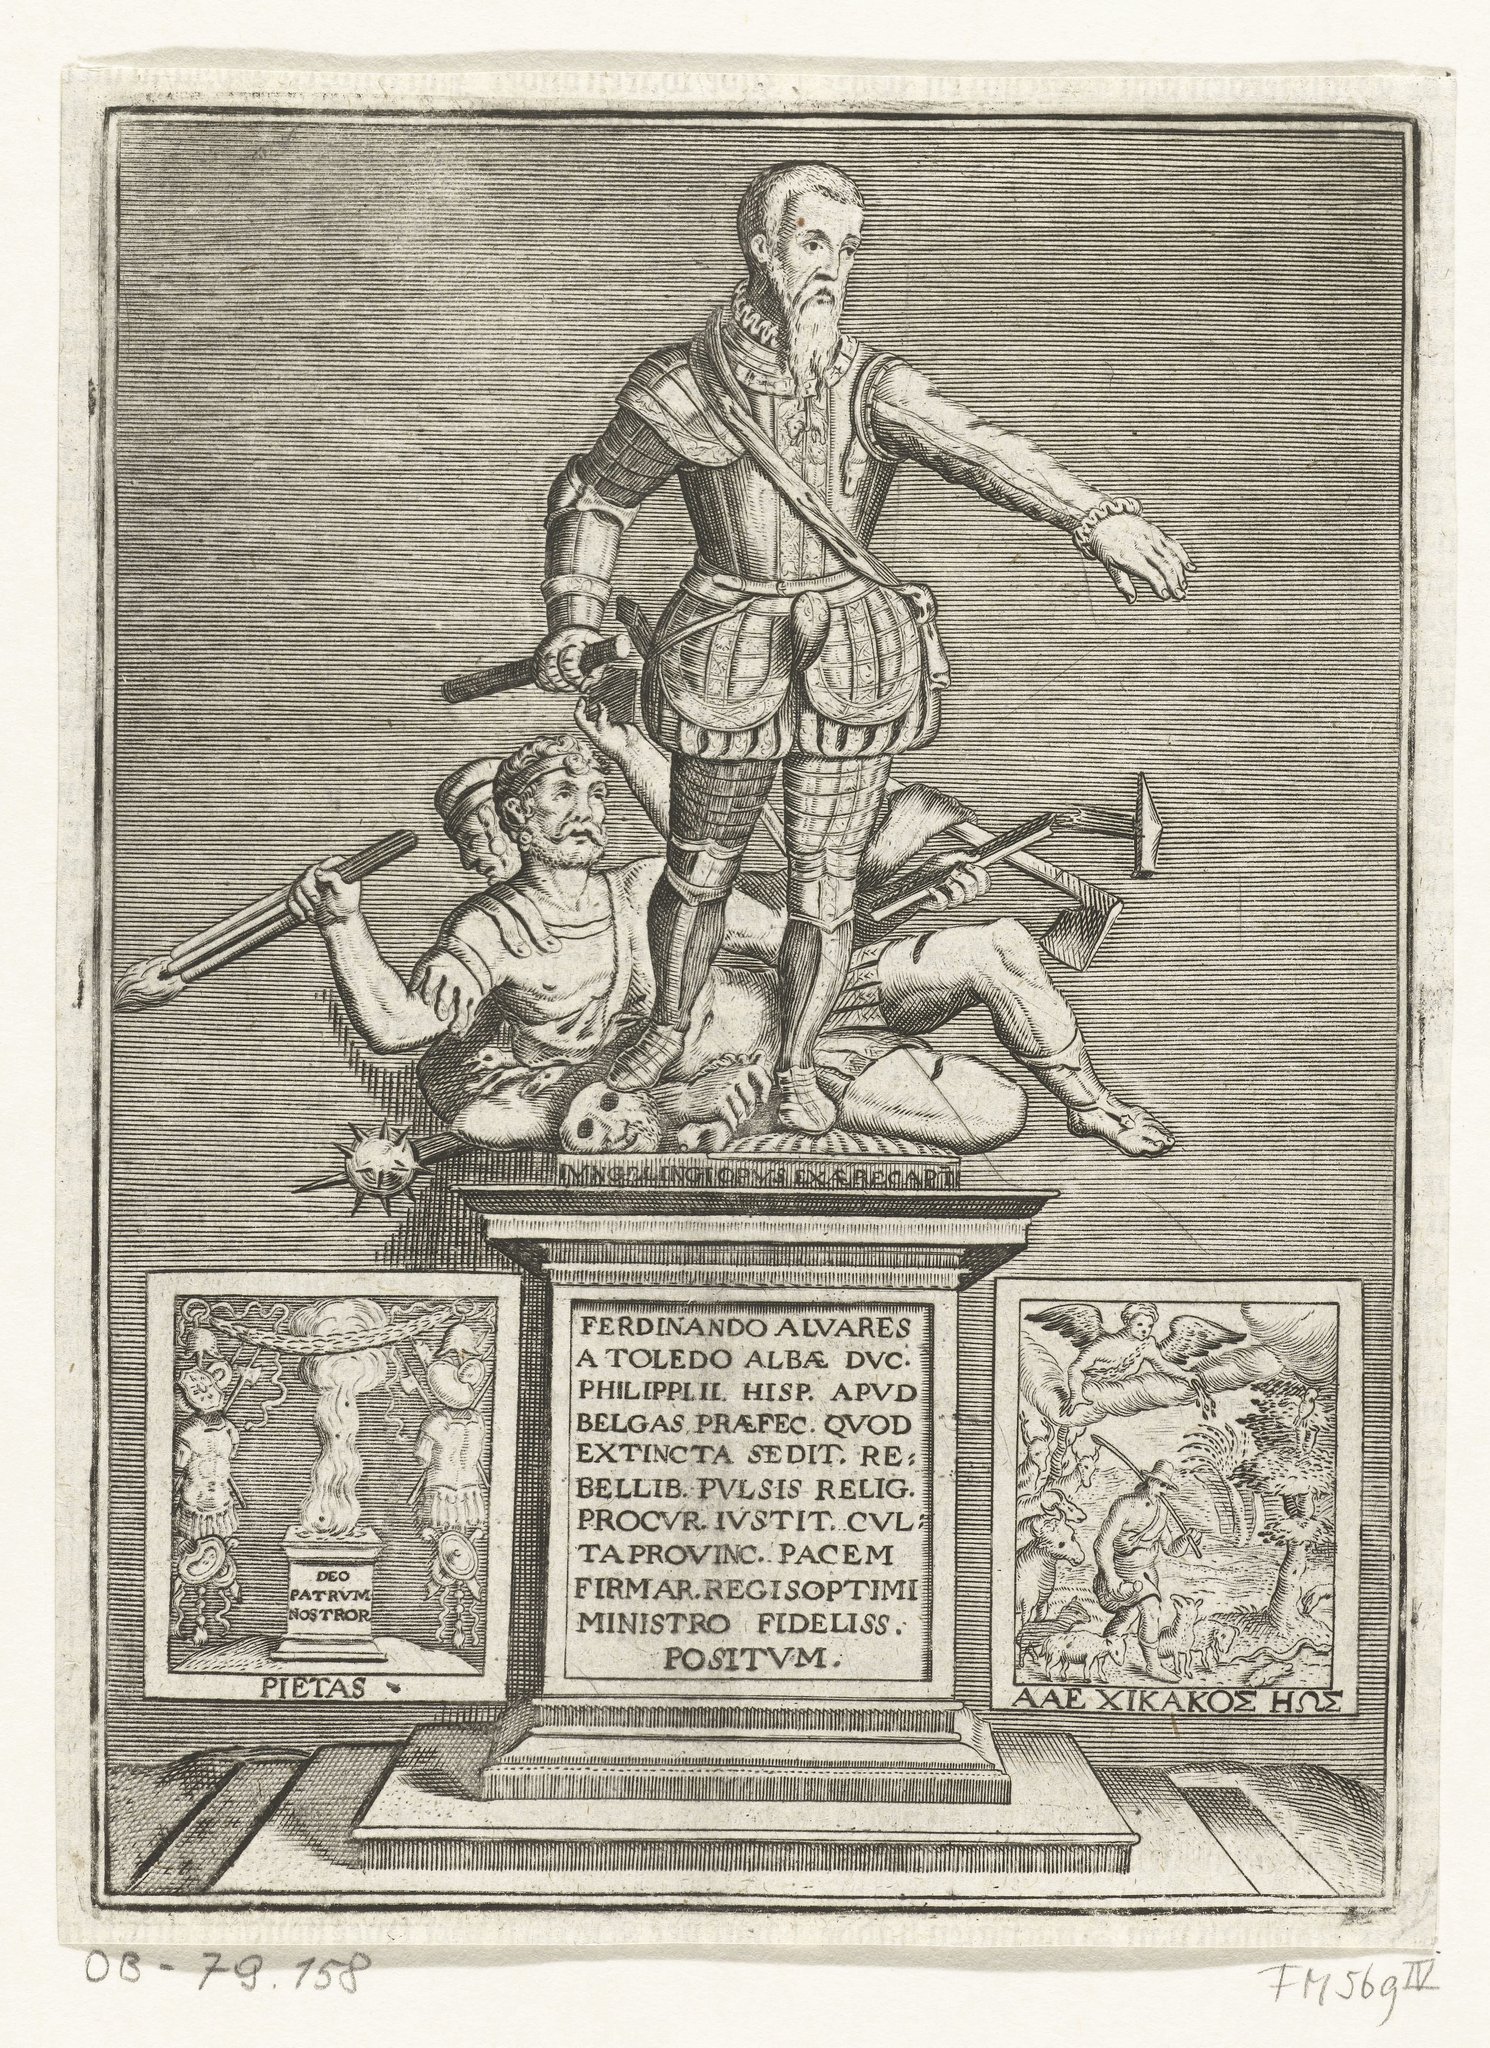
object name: print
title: Standbeeld van de hertog van Alva, 1571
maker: Anonymous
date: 1600-1699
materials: paper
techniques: engraving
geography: low countries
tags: fernando álvarez de toledo (3rd duke of alba), piece of sculpture, reproduction of a piece of sculpture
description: Het standbeeld van de hertog van Alva, door hemzelf opgericht op de binnenplaats van de citadel te Antwerpen, 1571. Met de twee voorstellingen op de zijden van het voetstuk. Bedrukt op de achterzijde met tekst in het Nederlands.